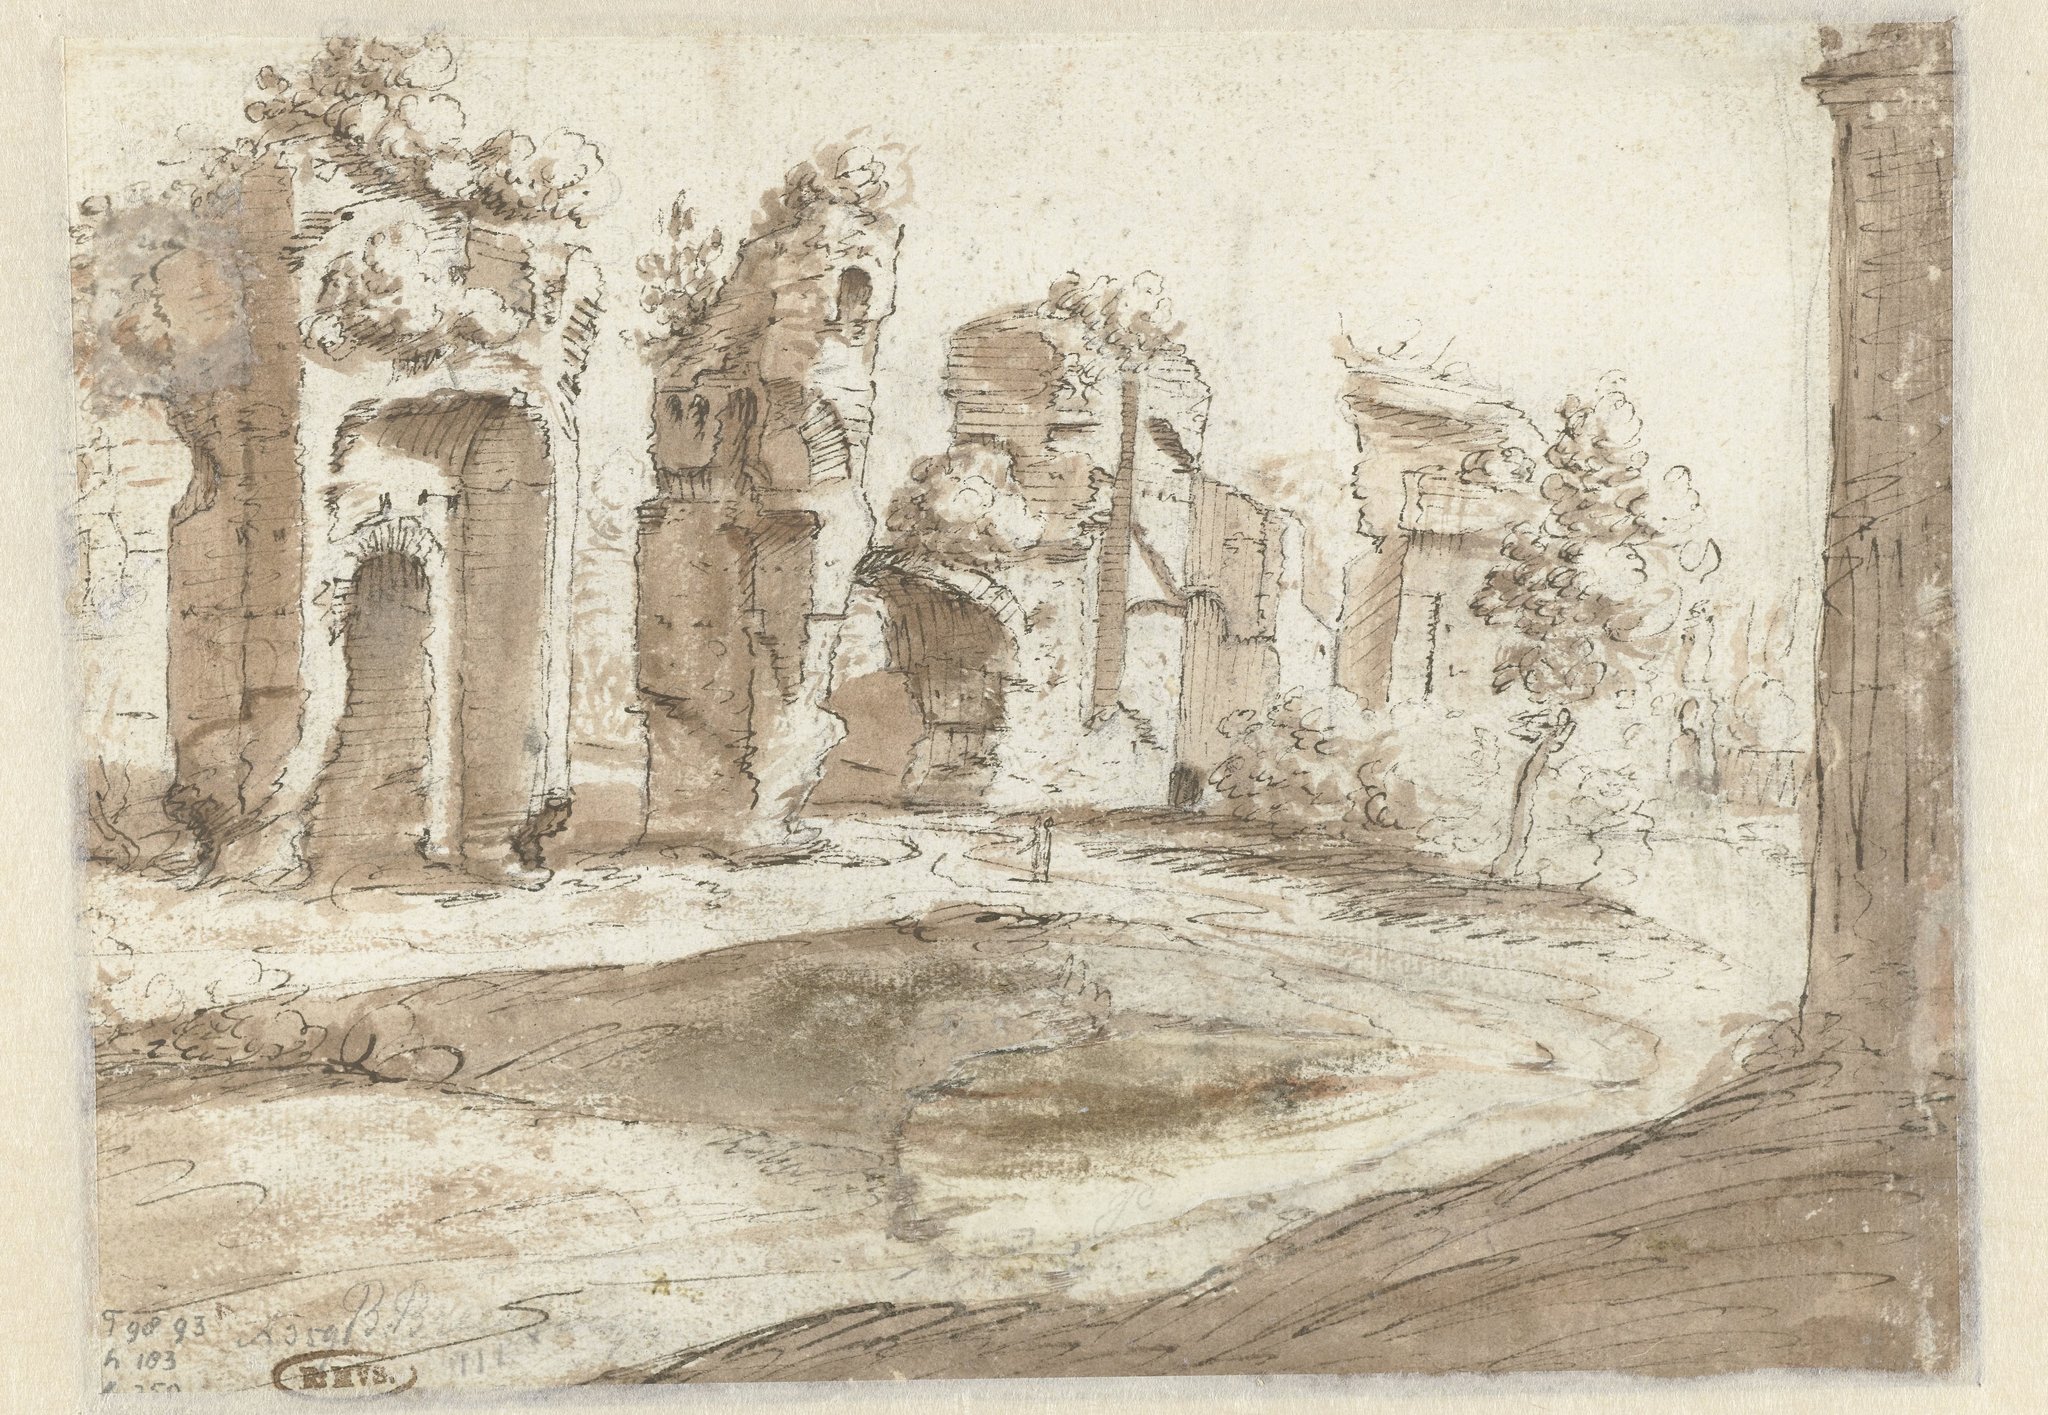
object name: drawing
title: Gezicht op antieke ruïnes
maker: Anonymous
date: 1600-1699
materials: graphite, ink, paper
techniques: brush, pen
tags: ruin of a building ~ architecture, landscape with ruins, italy